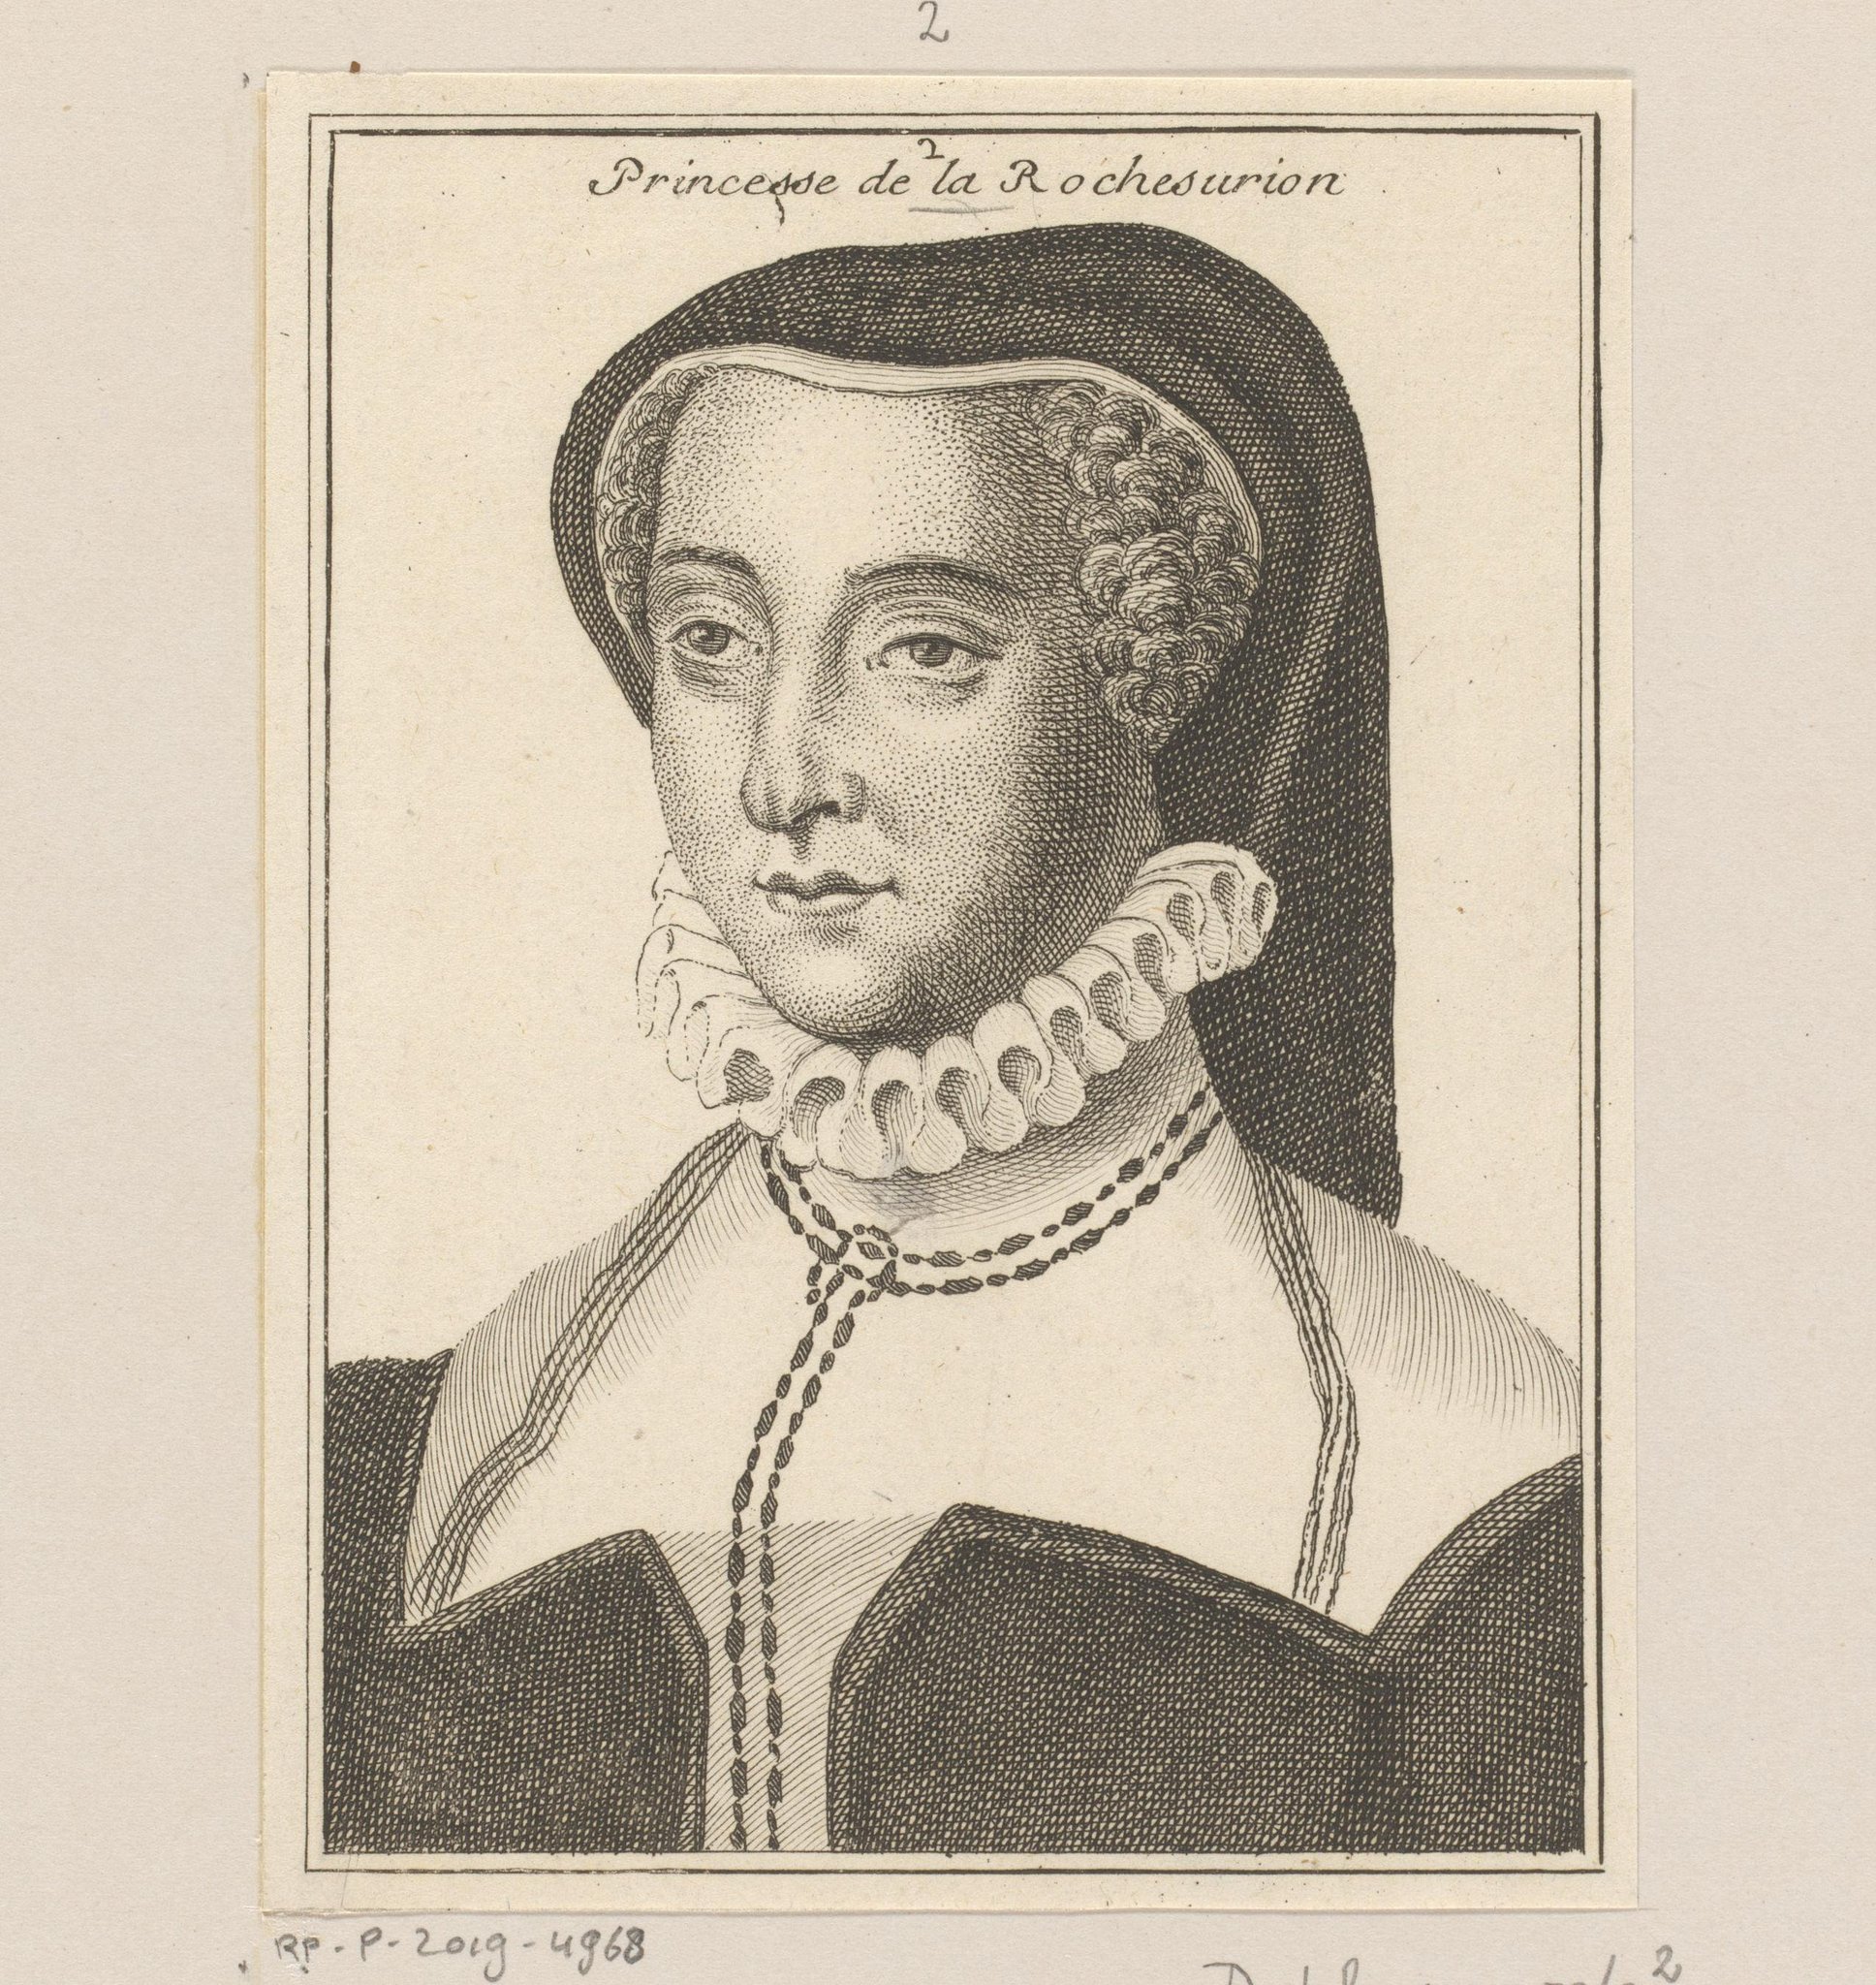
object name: book illustration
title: Portret van Philippes de Montespedon, prinses van La Roche-sur-Yon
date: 1729-1733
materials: paper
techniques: etching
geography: paris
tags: historical persons - bb - woman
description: Prent uit: Montfaucon, Bernard de. Les monumens de la Monarchie Françoise (...). Parijs: Julien-Michel Gandouin en Pierre-François Giffart, 1729-1733.